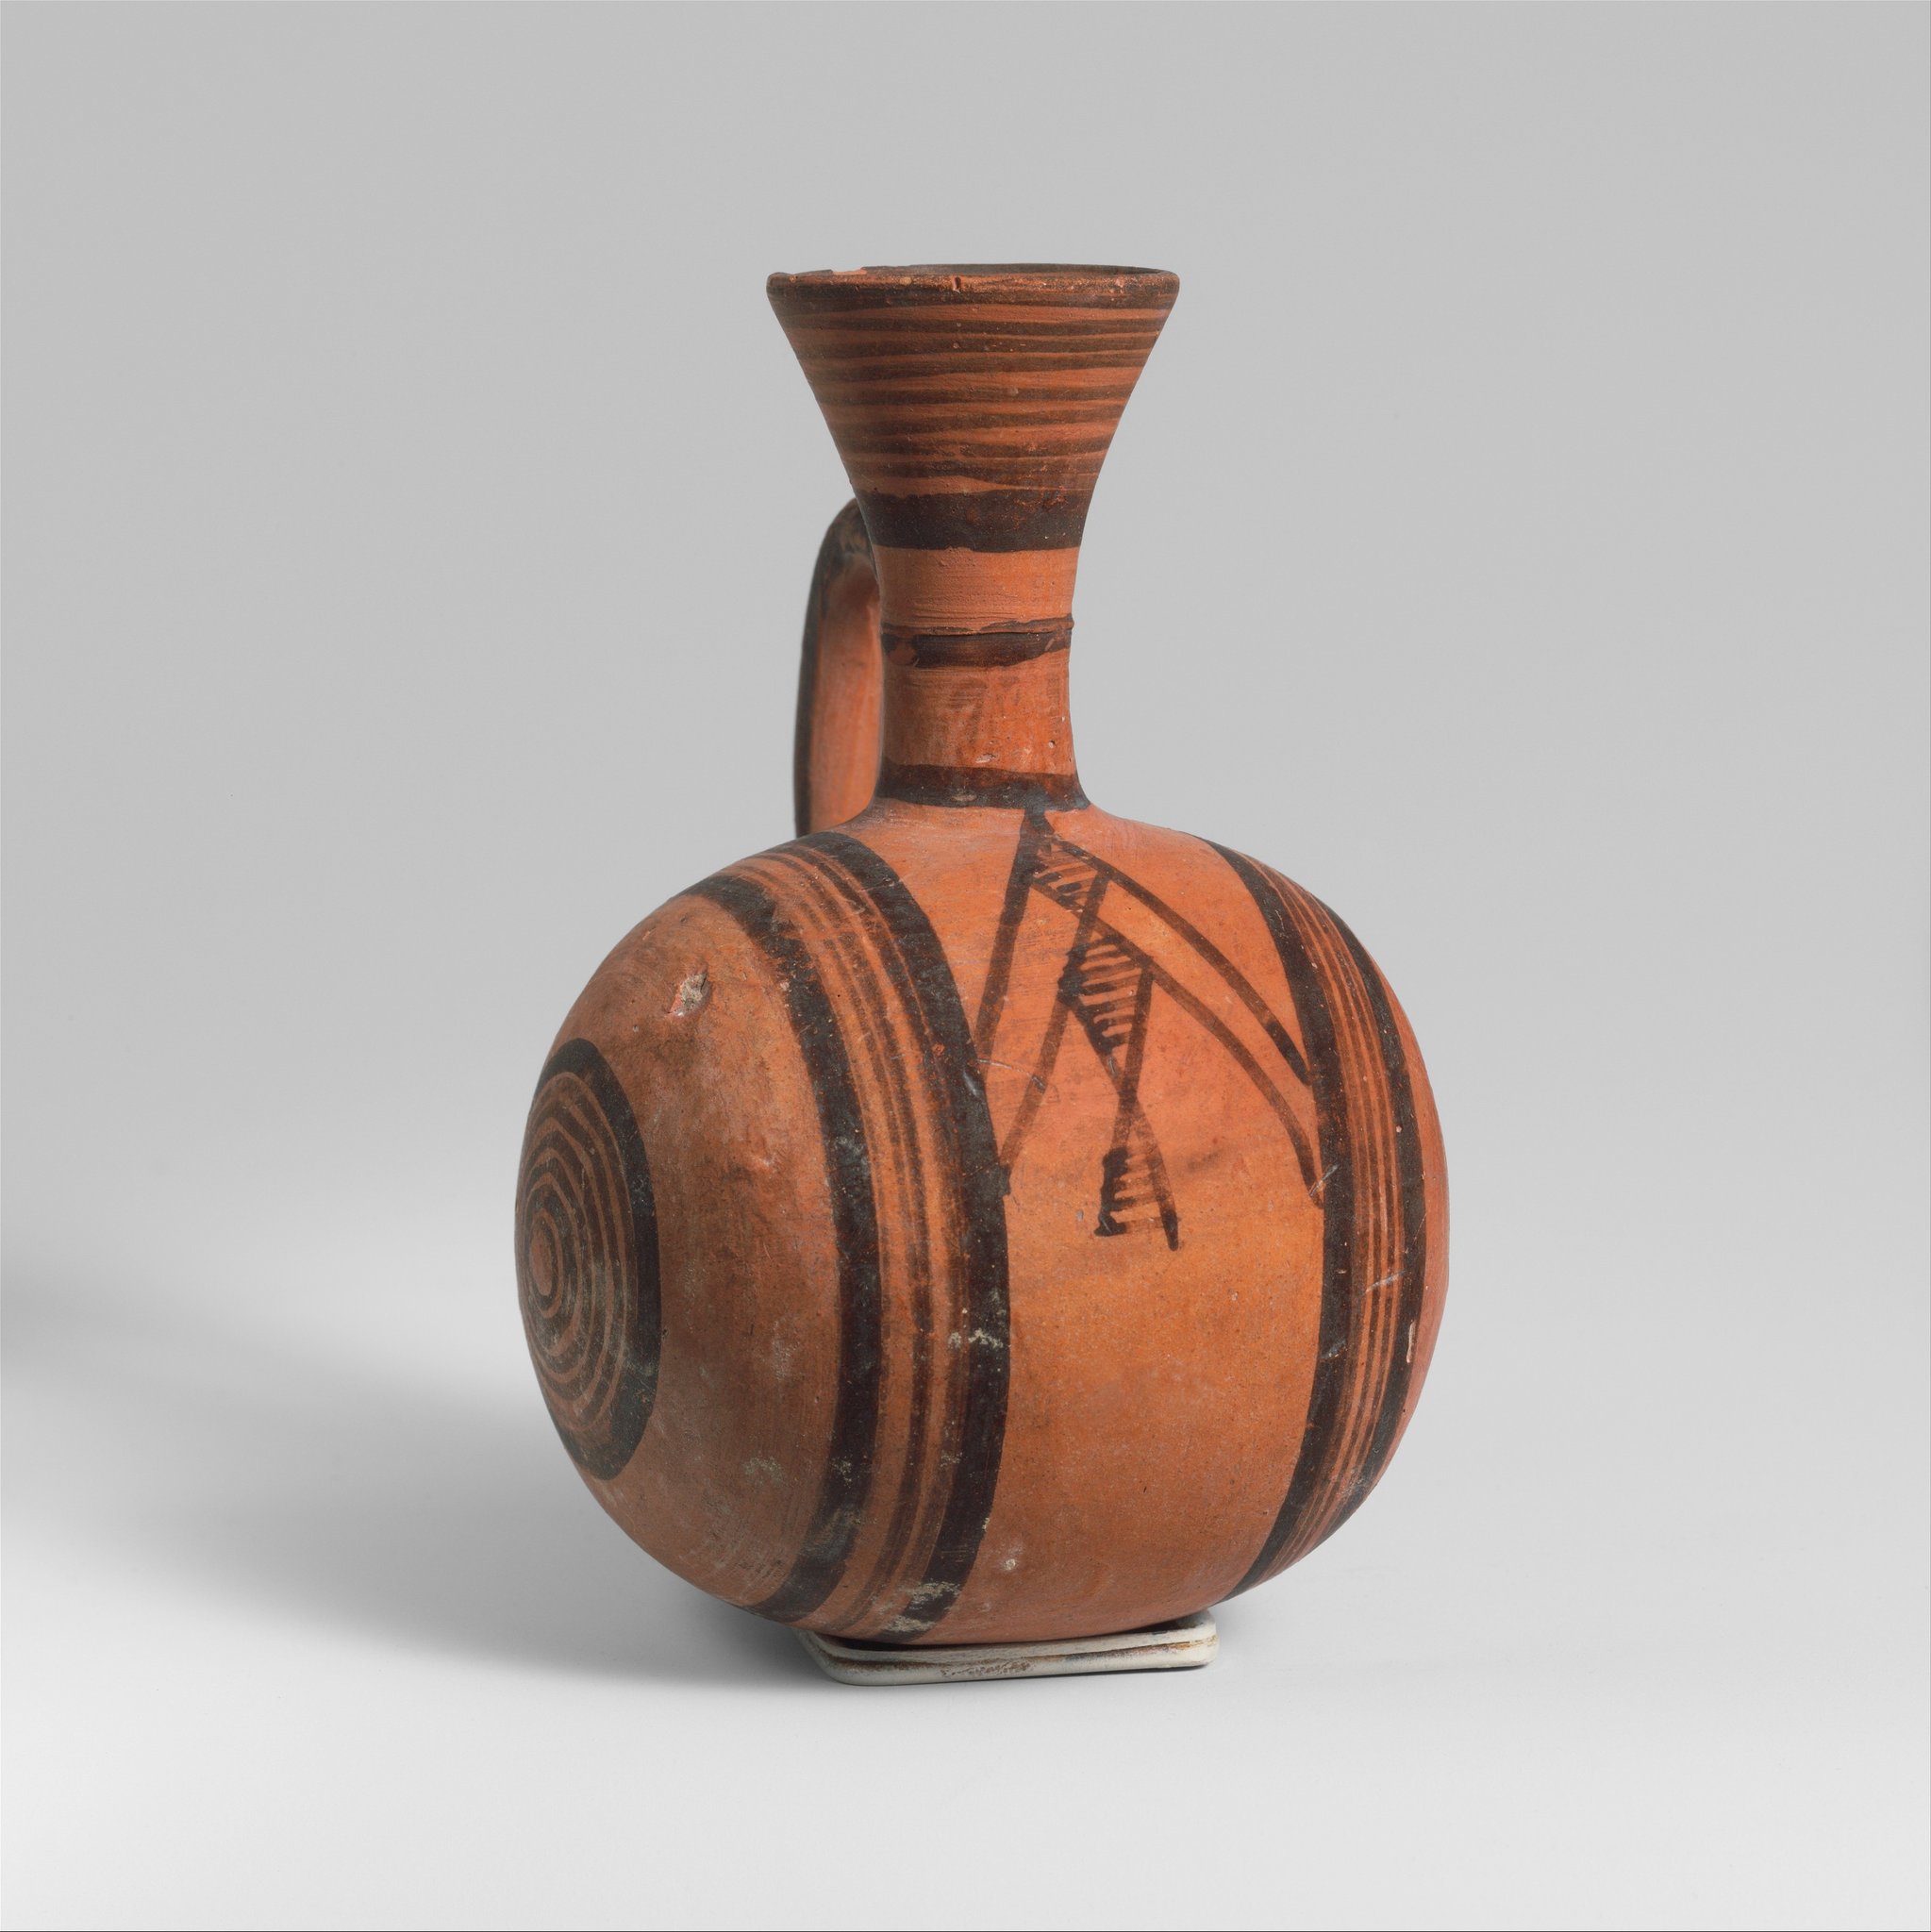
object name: jug, barrel shaped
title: Terracotta barrel-shaped jug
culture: cypriot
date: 850-750 BCE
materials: terracotta